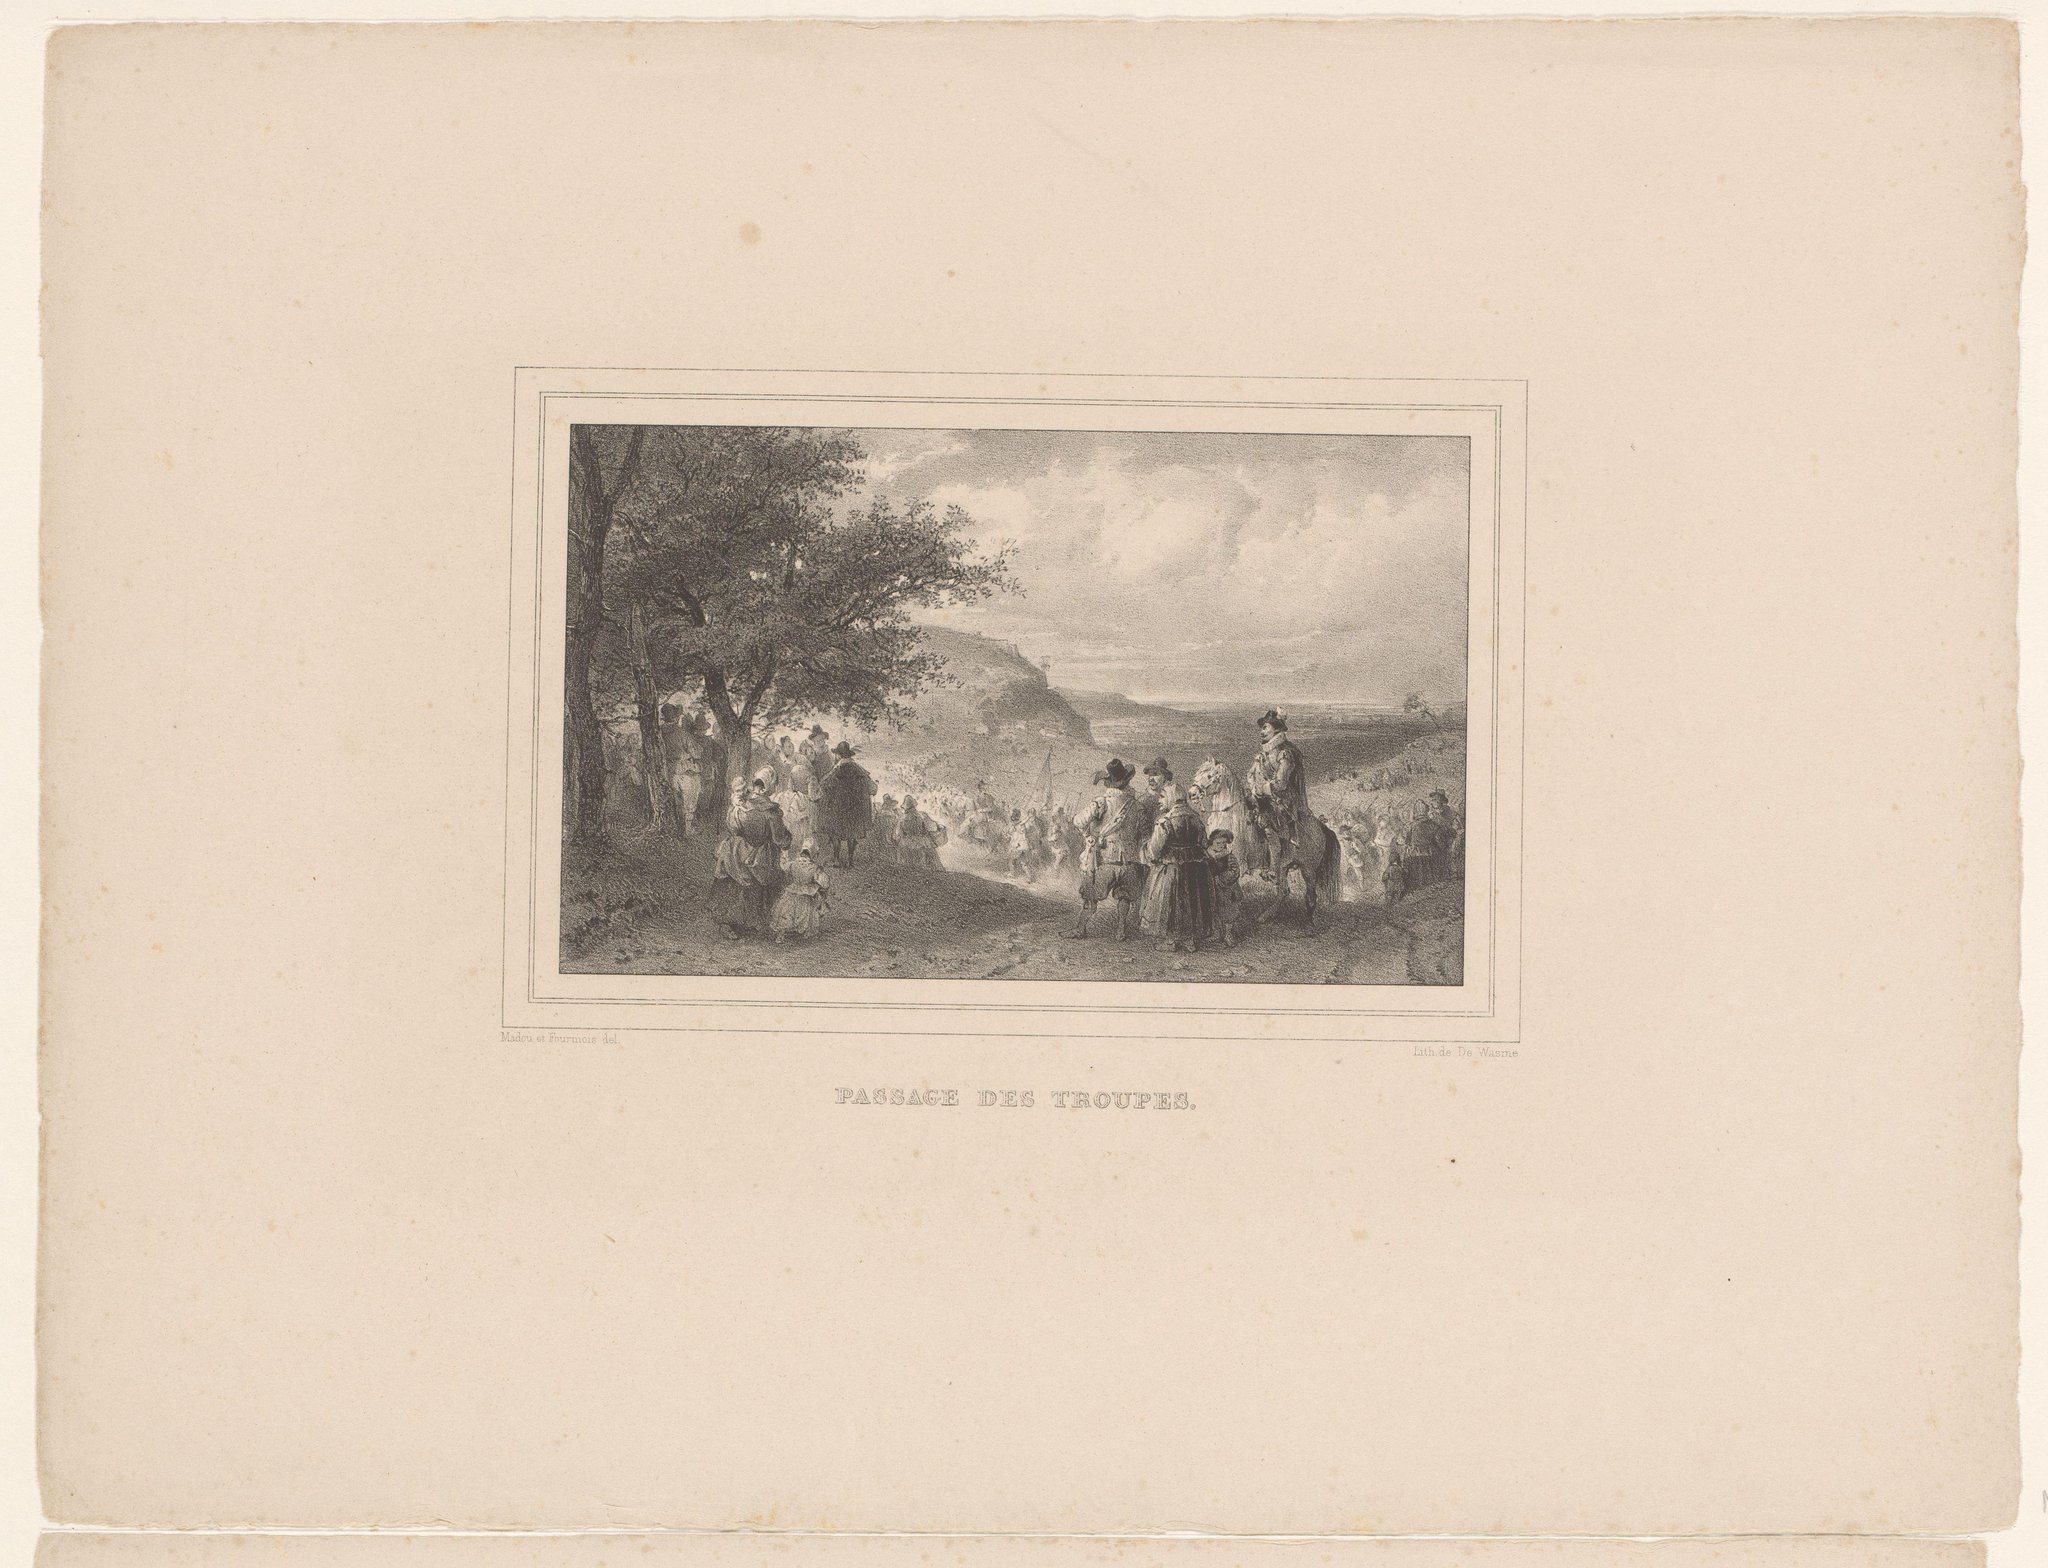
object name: print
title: Twaalf genretaferelen door Jean Baptiste Madou en Théodore Fourmois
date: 1834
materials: paper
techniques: lithograph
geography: brussels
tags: army 'en route', low hill country, the soldier; the soldier's life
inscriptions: collector's mark: Lugt 2228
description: Prent behoort tot een serie met twaalf genretaferelen vervaardigd door Madou en Fourmois. Vier prenten zijn enkel door Madou vervaardigd en de overige prenten door Madou en Fourmois samen. Madou vervaardigde de figuren en Fourmois het landschap.